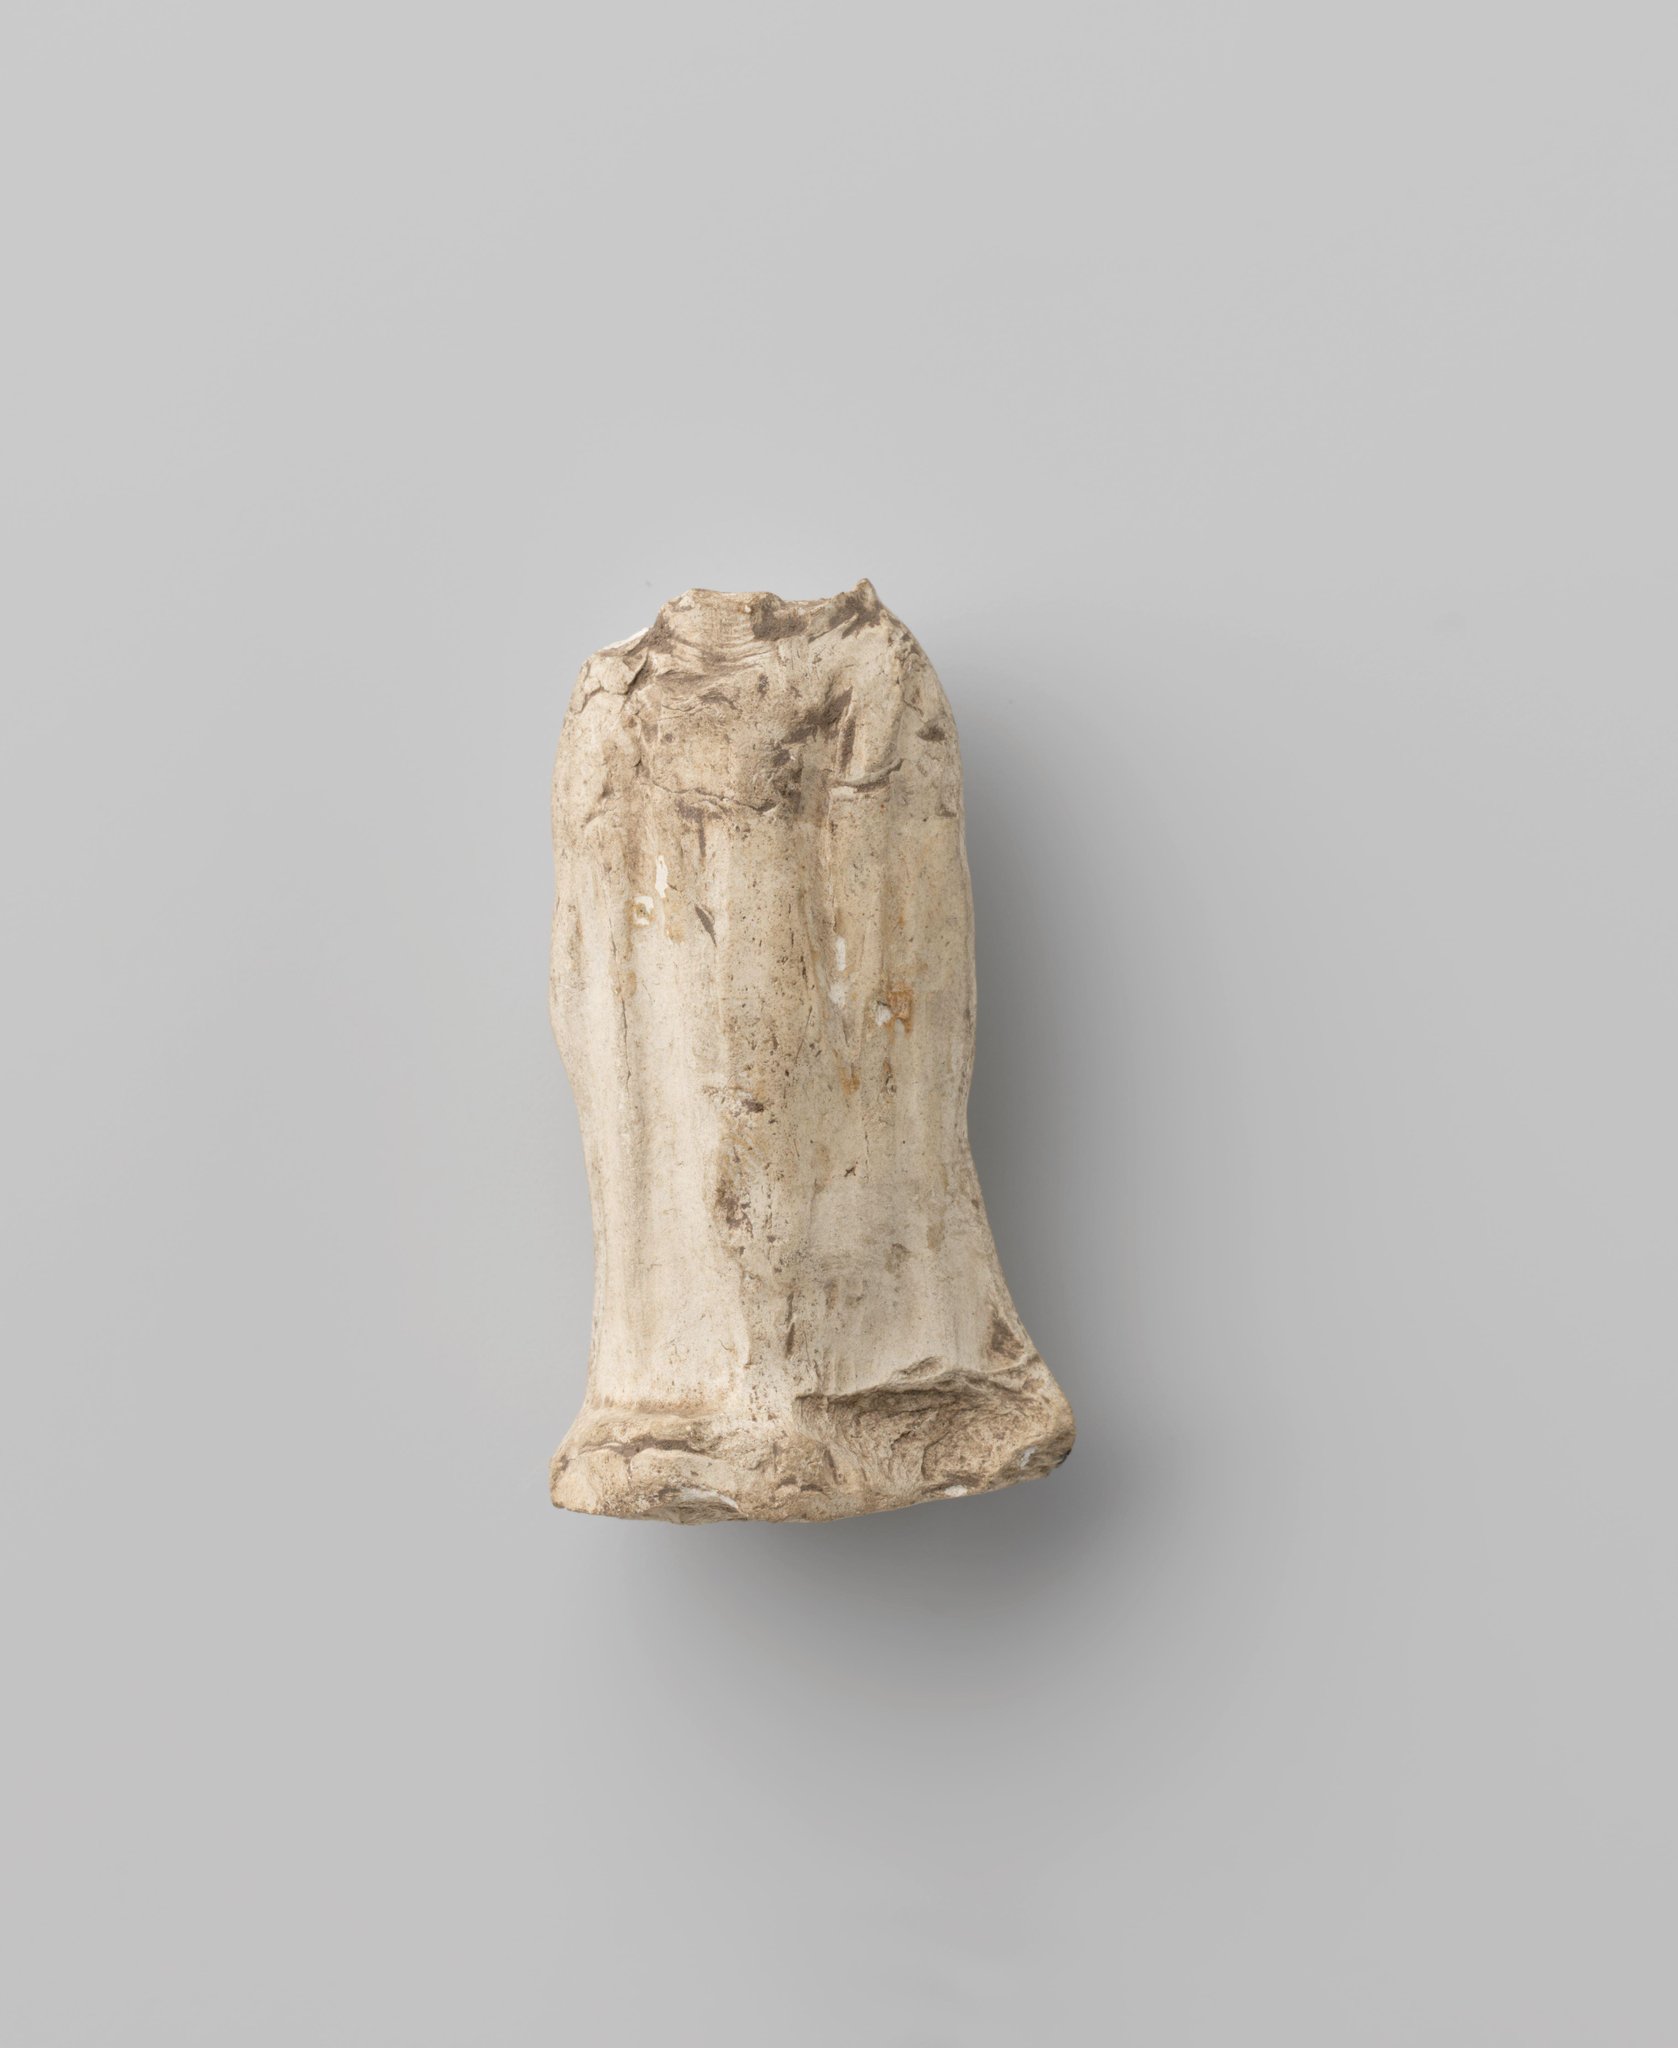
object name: figure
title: Beeld van een figuur in een mantel; het hoofd ontbreekt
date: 1400-1950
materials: clay